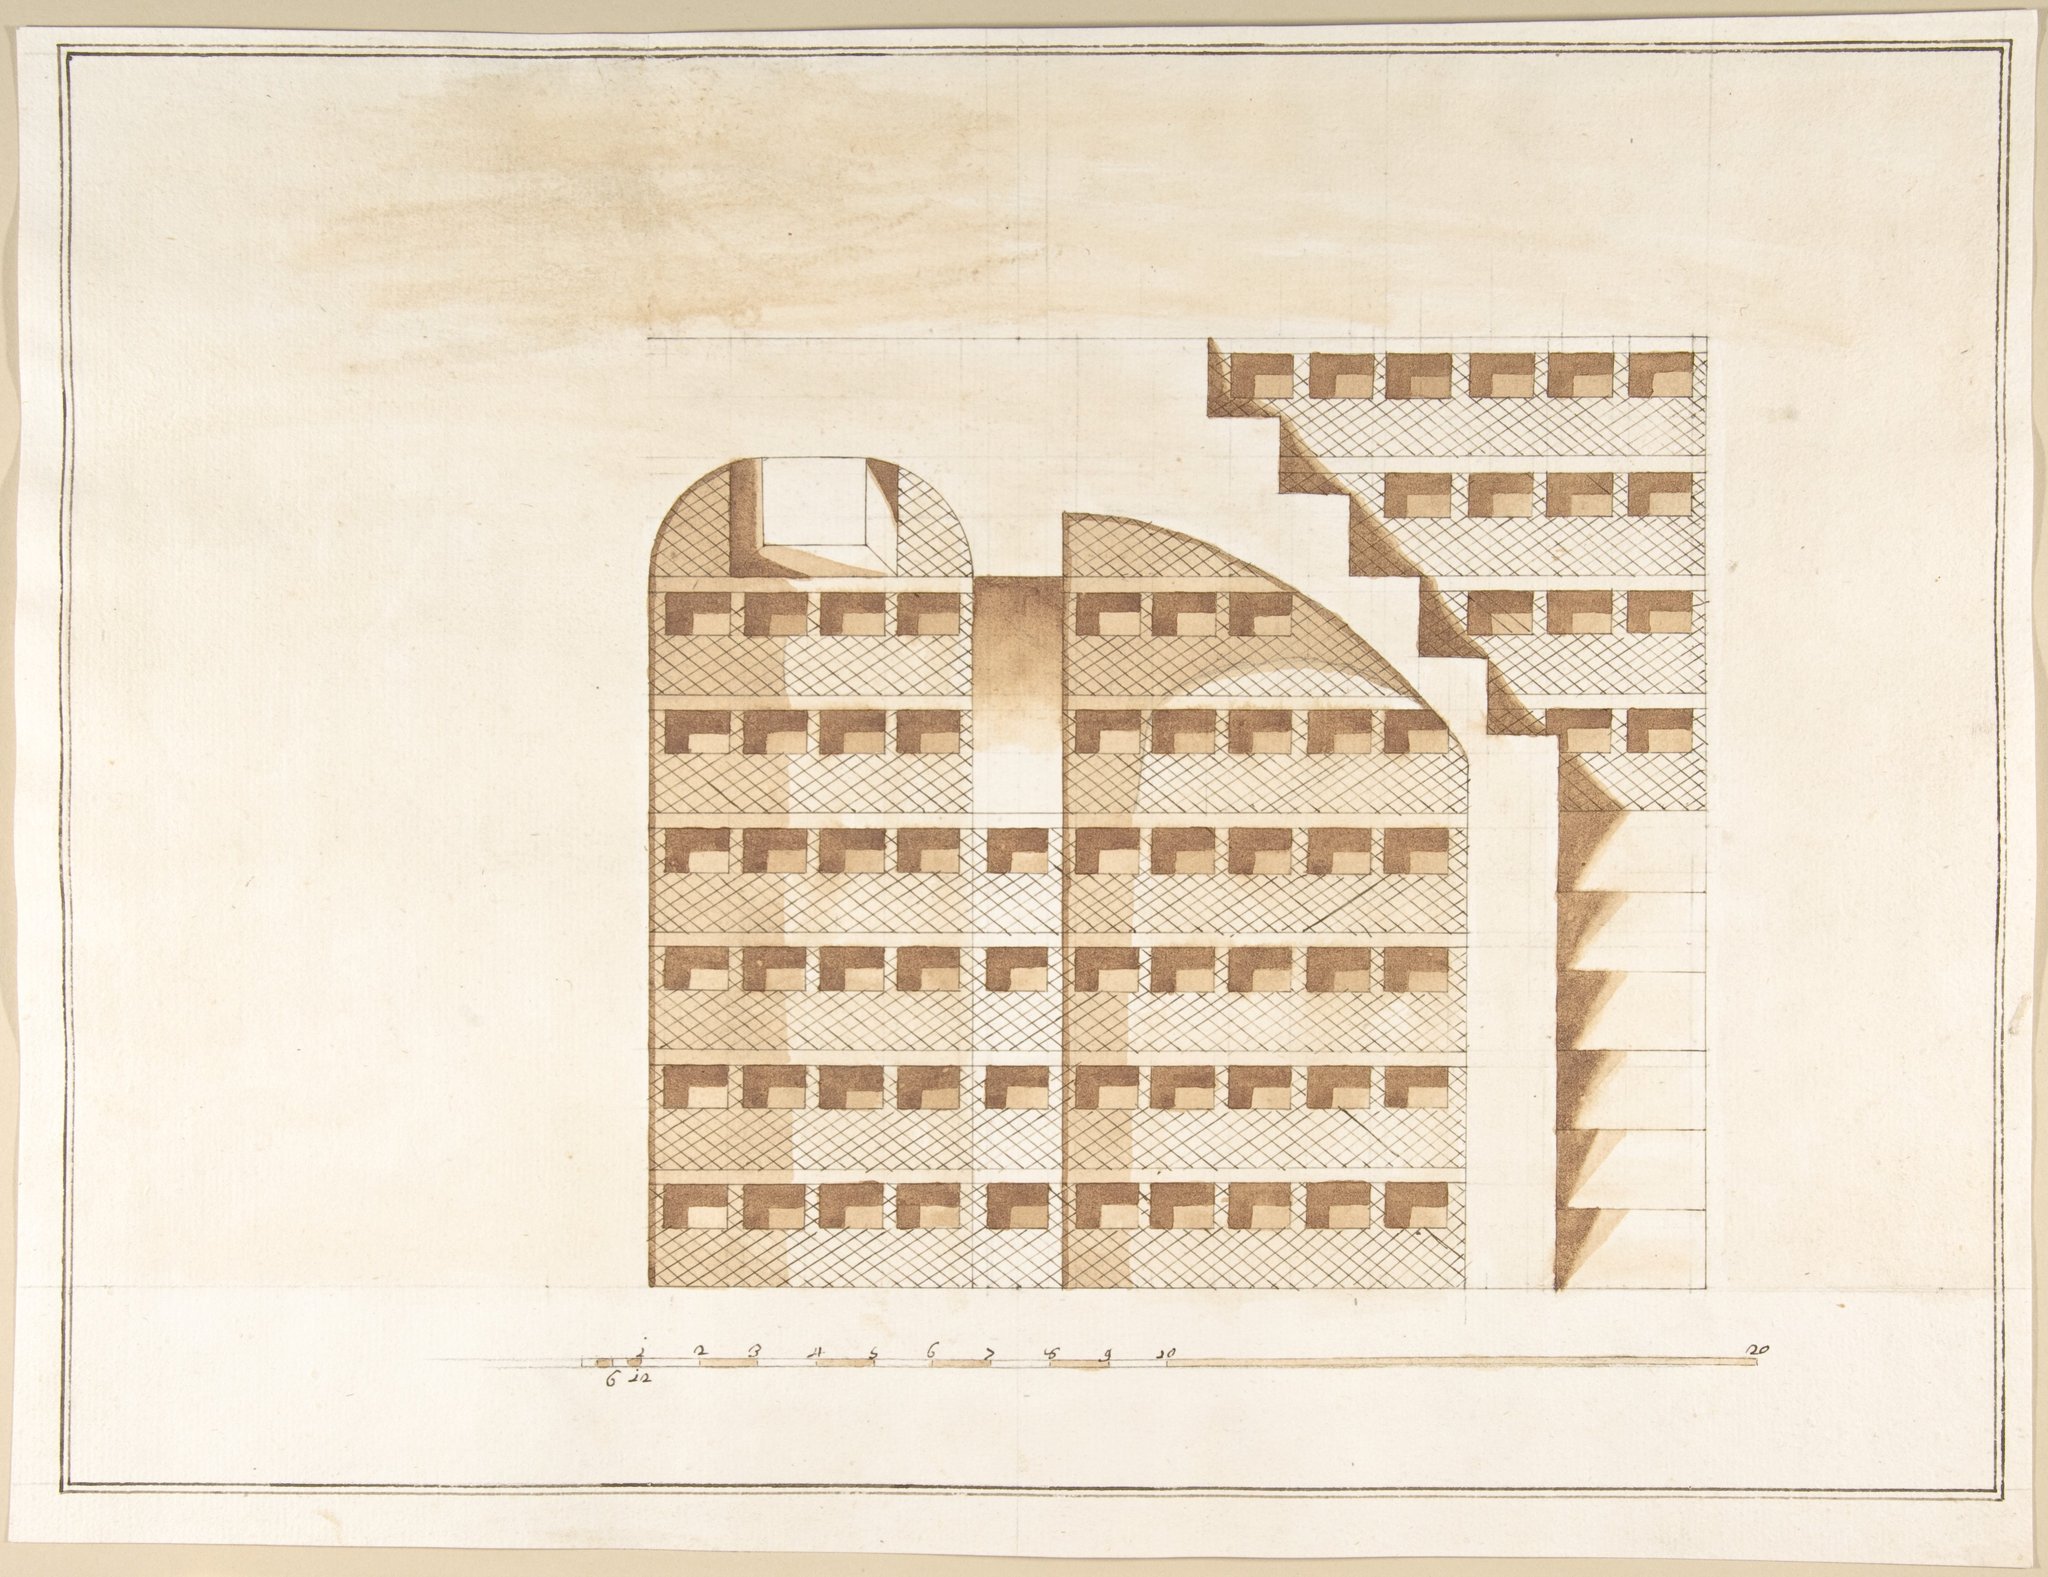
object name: drawing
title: Section of a Columbarium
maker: pietro paolo coccetti (cocchetti)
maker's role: artist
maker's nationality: italian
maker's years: 1710-1727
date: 1710-1727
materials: graphite, ink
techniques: brush, pen, wash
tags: architecture